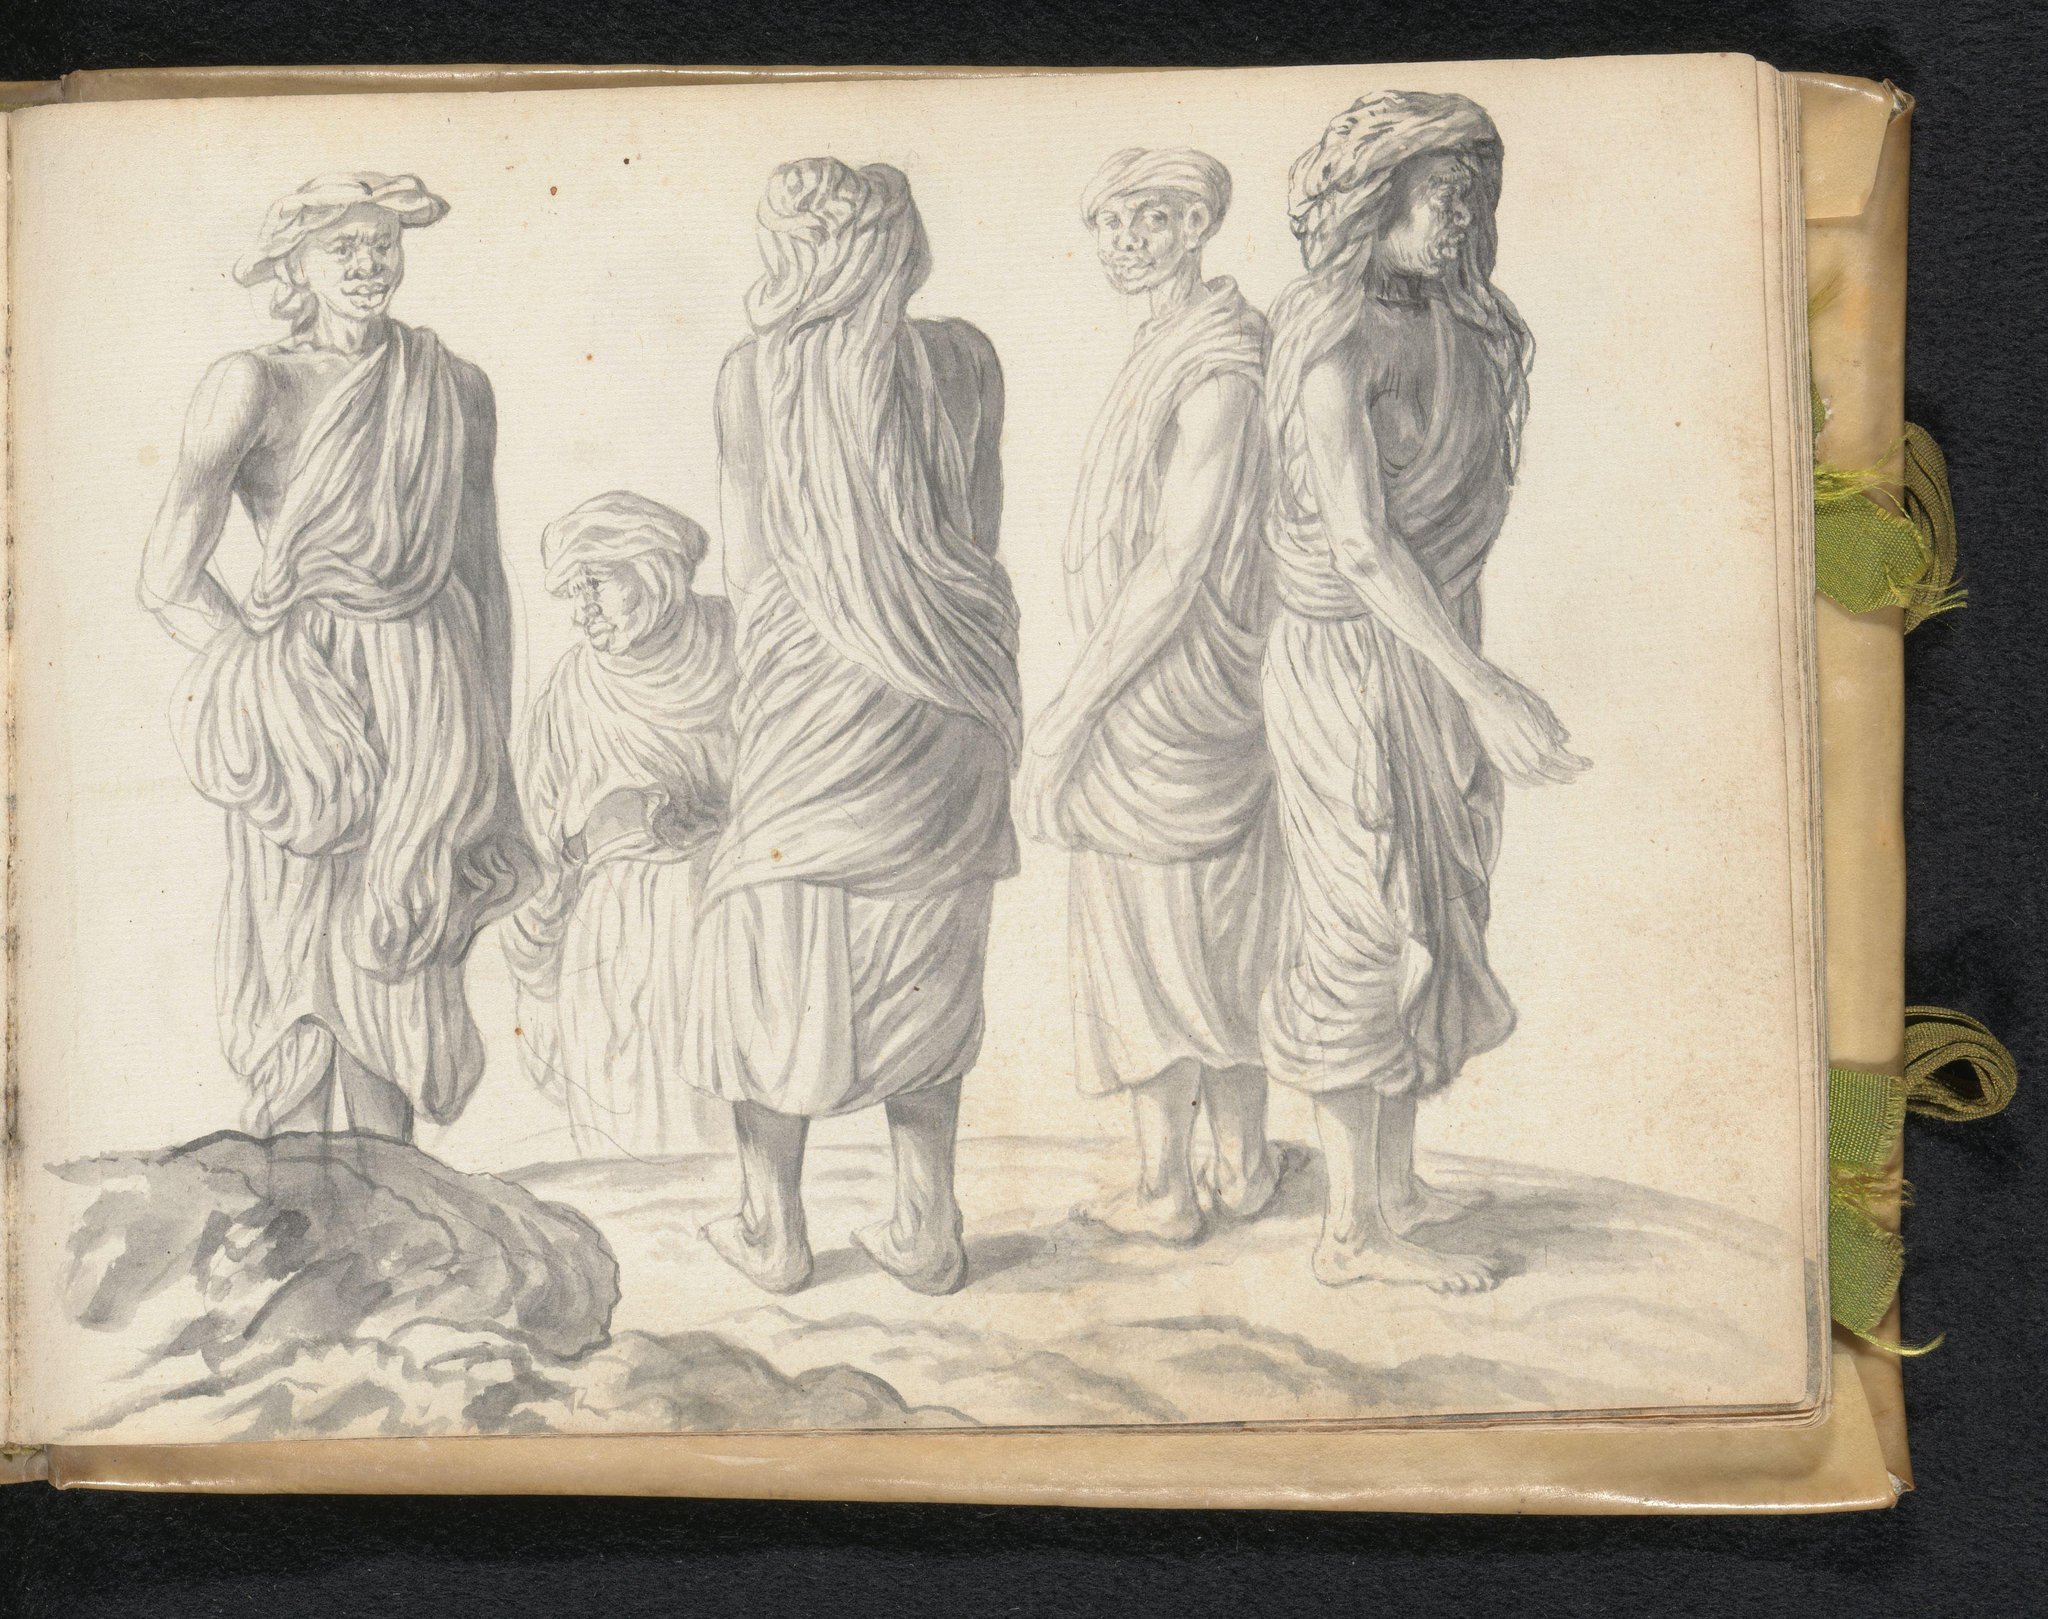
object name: sketchbook leaf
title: Five women labourers at the roadside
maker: esaias boursse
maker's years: 1631-1672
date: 1662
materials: ink, paper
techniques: brush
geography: sri lanka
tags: clothes covering the entire body (with name), asiatic races and peoples: indians, working class, labourers - aa - women, sri lanka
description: Groep van vijf vrouwen buiten op een hellende weg. De gezichten tonen Zuid-Indiase trekken. Alle vijf zijn ze gekleed in een lang Zuid-Indiaas wikkelkleed (selai of sari) dat via rug en schouder over het bovenlijf geslagen weer in de taille is vastgestoken en de borsten bedekt. Alle vijf vrouwen hebben hun hoofd en haar bedekt met een hoofddoek in uiteenlopend formaat: van heel eenvoudig tot dik omwikkeld. De vrouw links staat met haar voeten achter een berg aarde. Het zijn waarschijnlijk uit Zuid-India of Jaffna afkomstige arbeiders, naar Colombo overgebracht voor grondwerk. Blad 105 uit een schetsboek met 117 bladen.